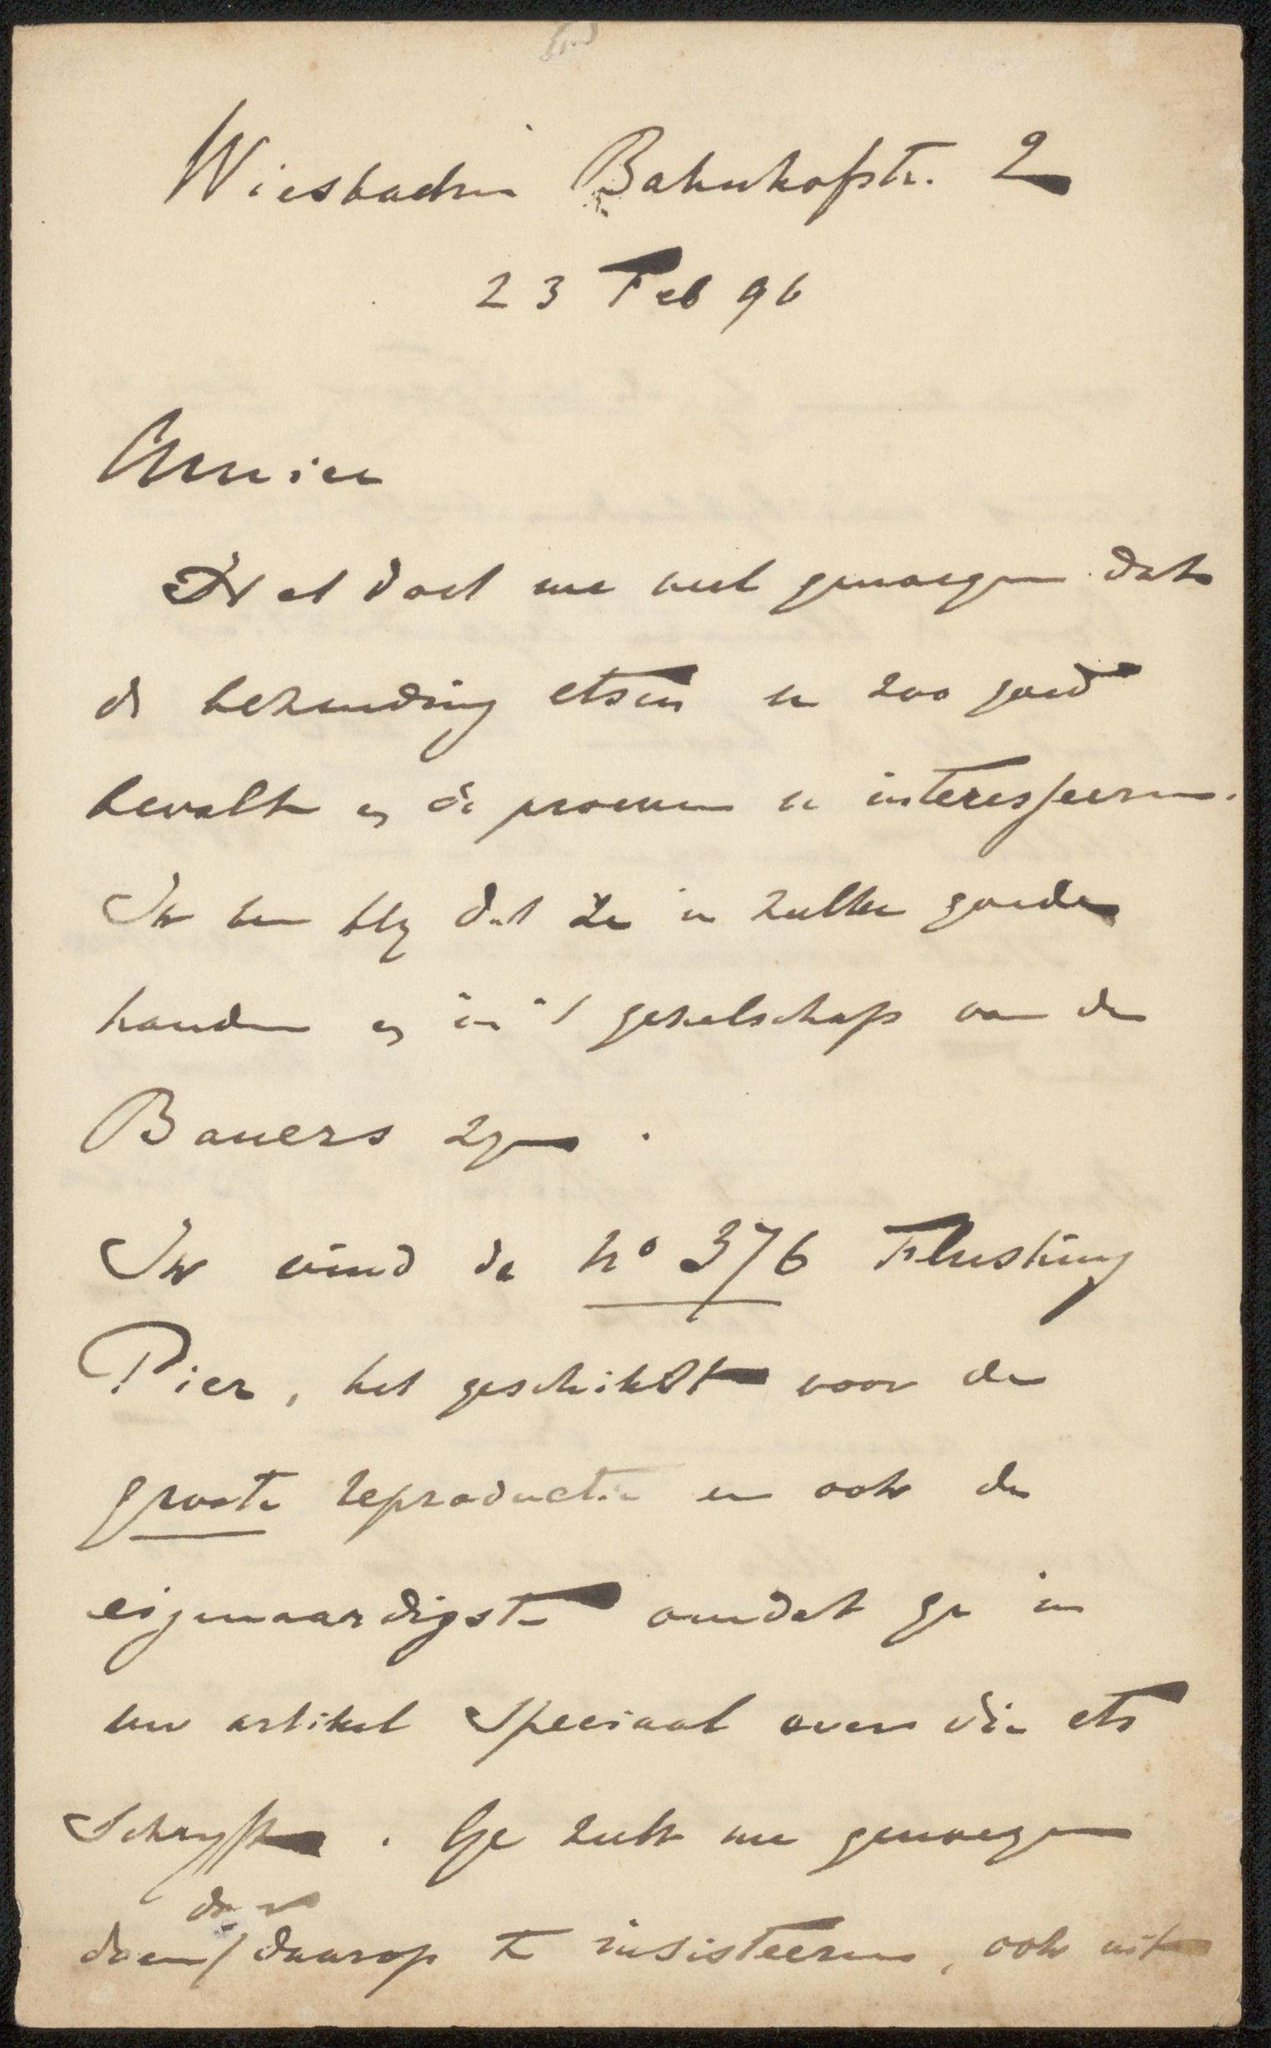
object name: letter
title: Brief aan Philip Zilcken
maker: carel nicolaas storm van s-gravesande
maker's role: draughtsman, print maker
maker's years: 1841-1924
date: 1896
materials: ink, paper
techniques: pen, writing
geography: wiesbaden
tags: vincent van gogh, the hague, amsterdam, print maker, draughtsman, marius bauer, hermanus gijsbertus tersteeg, philip zilcken, the graphic arts, illustration ~ printed matter, book, printed matter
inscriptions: watermark, collector's mark: ‘RPK’